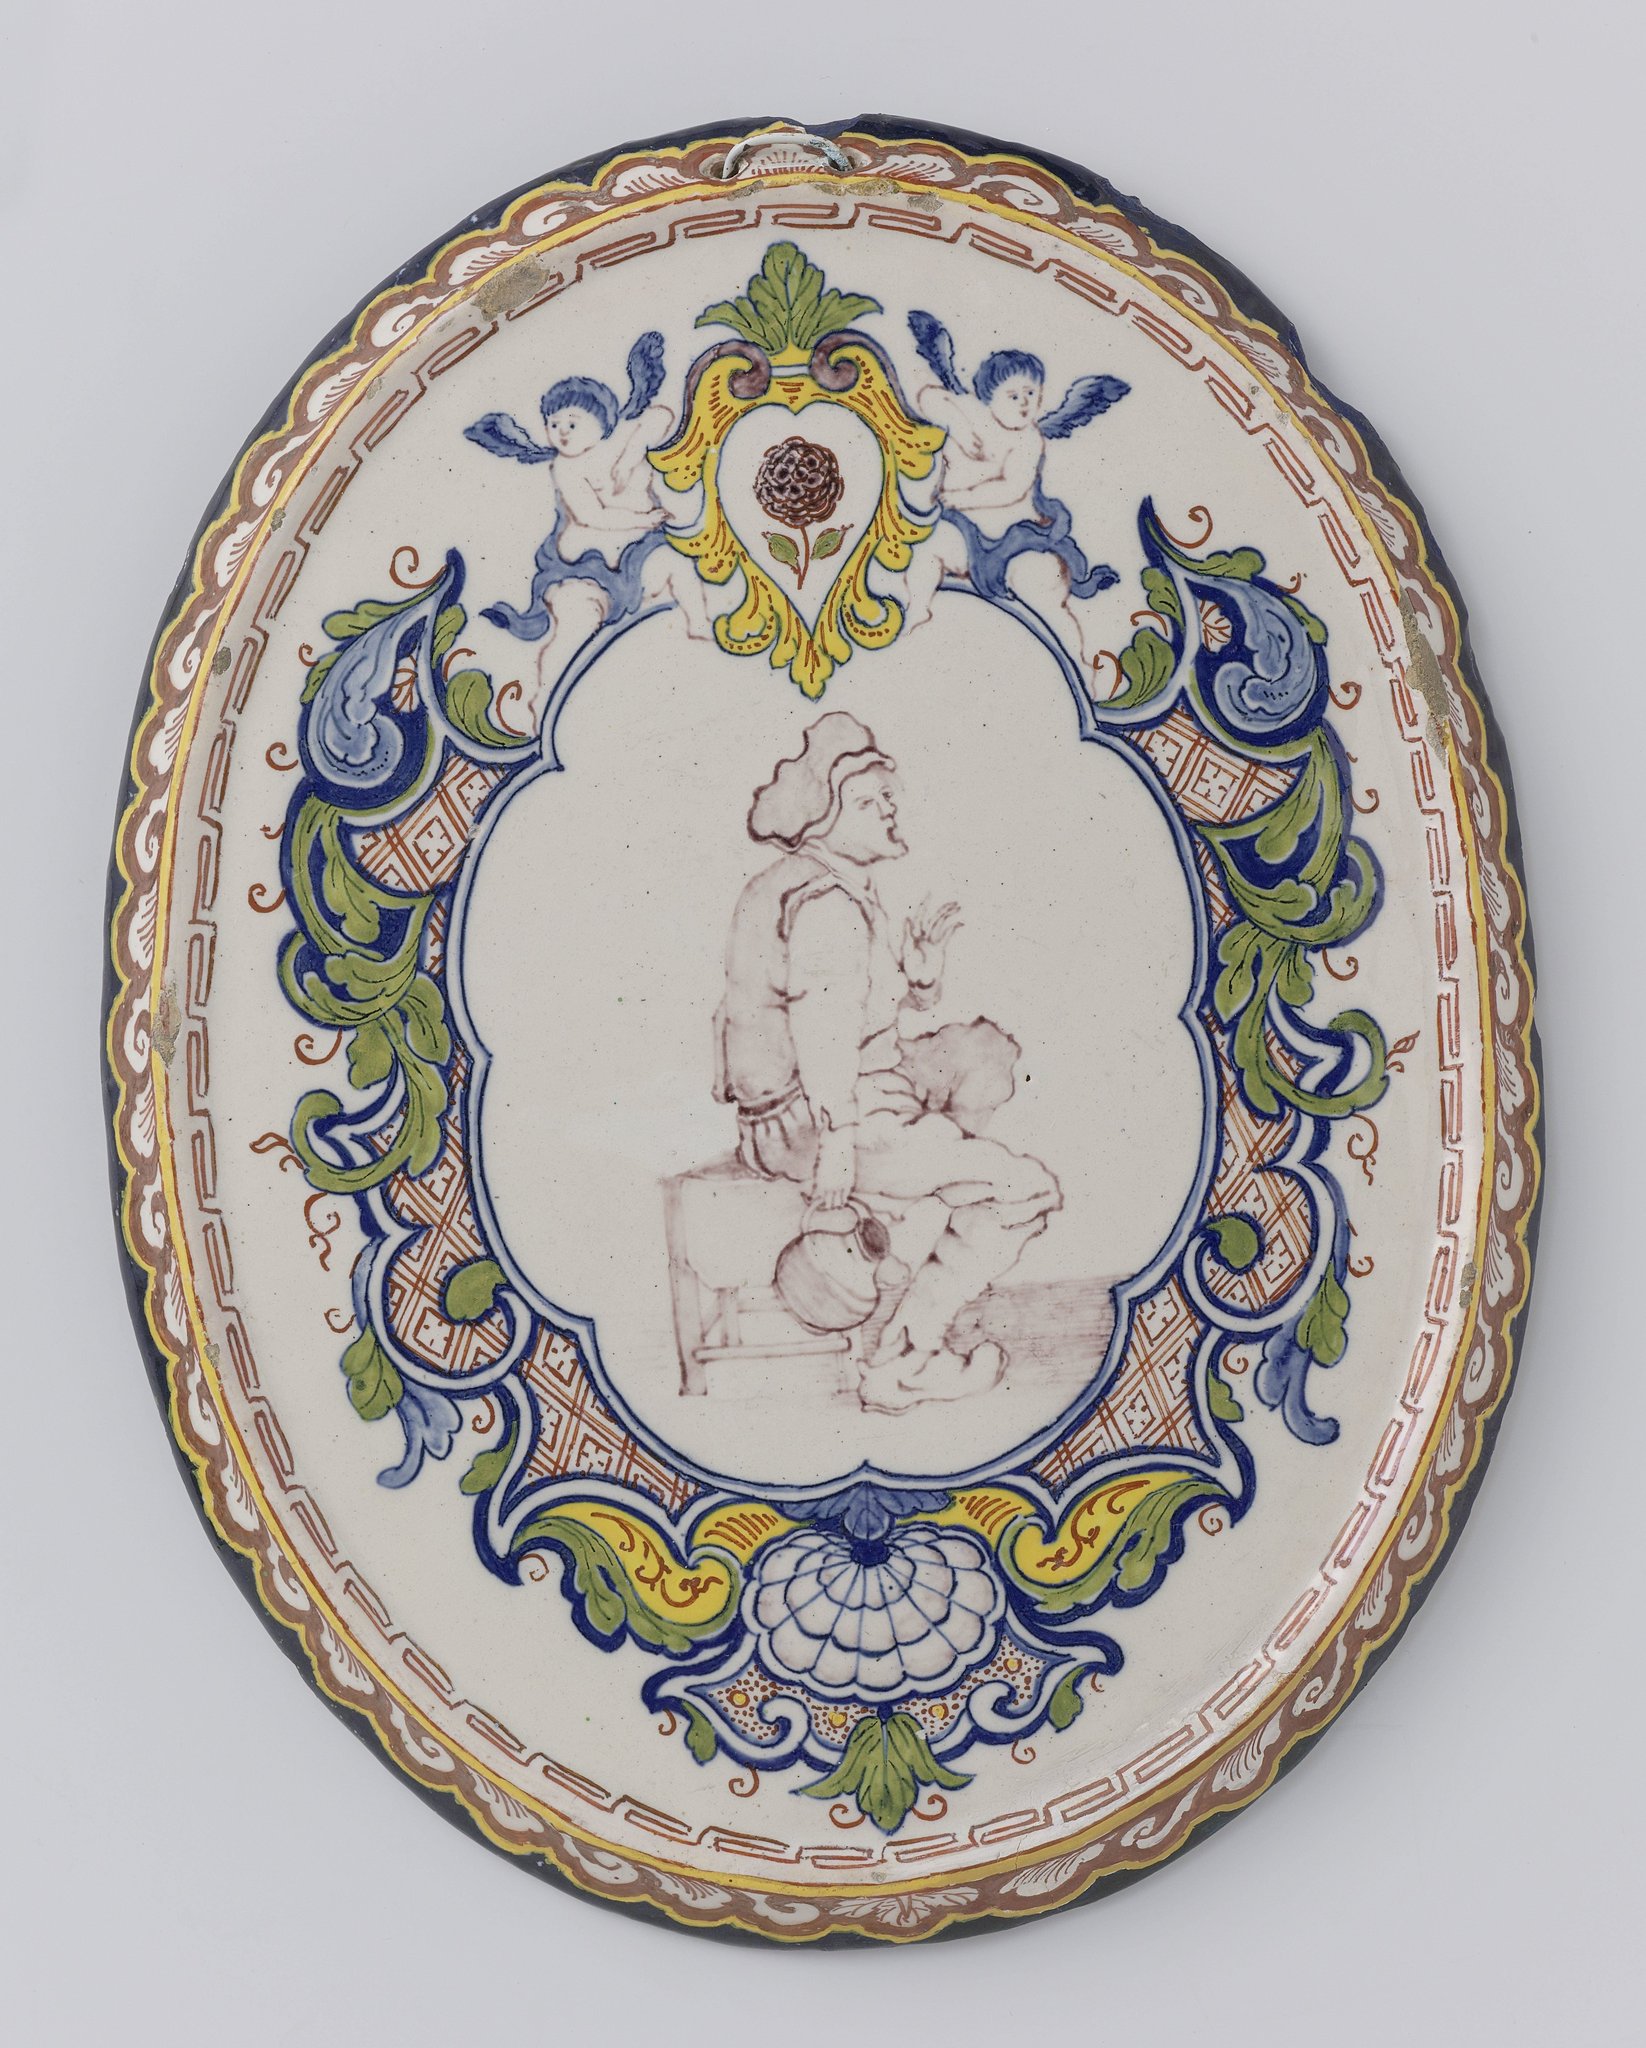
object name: plate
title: Plaat, ovaal, veelkleurig beschilderd met een boer zittend binnen lambrequinrand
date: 1750-1775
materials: faience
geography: delft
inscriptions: collector's mark: ‘collection J.F. Loudon’, inscription: ‘2’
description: Plaat van faïence. Veelkleurig beschilderd met een boer zittend binnen een lambrequinrand, naar een prent van Cornelis Saftleven.